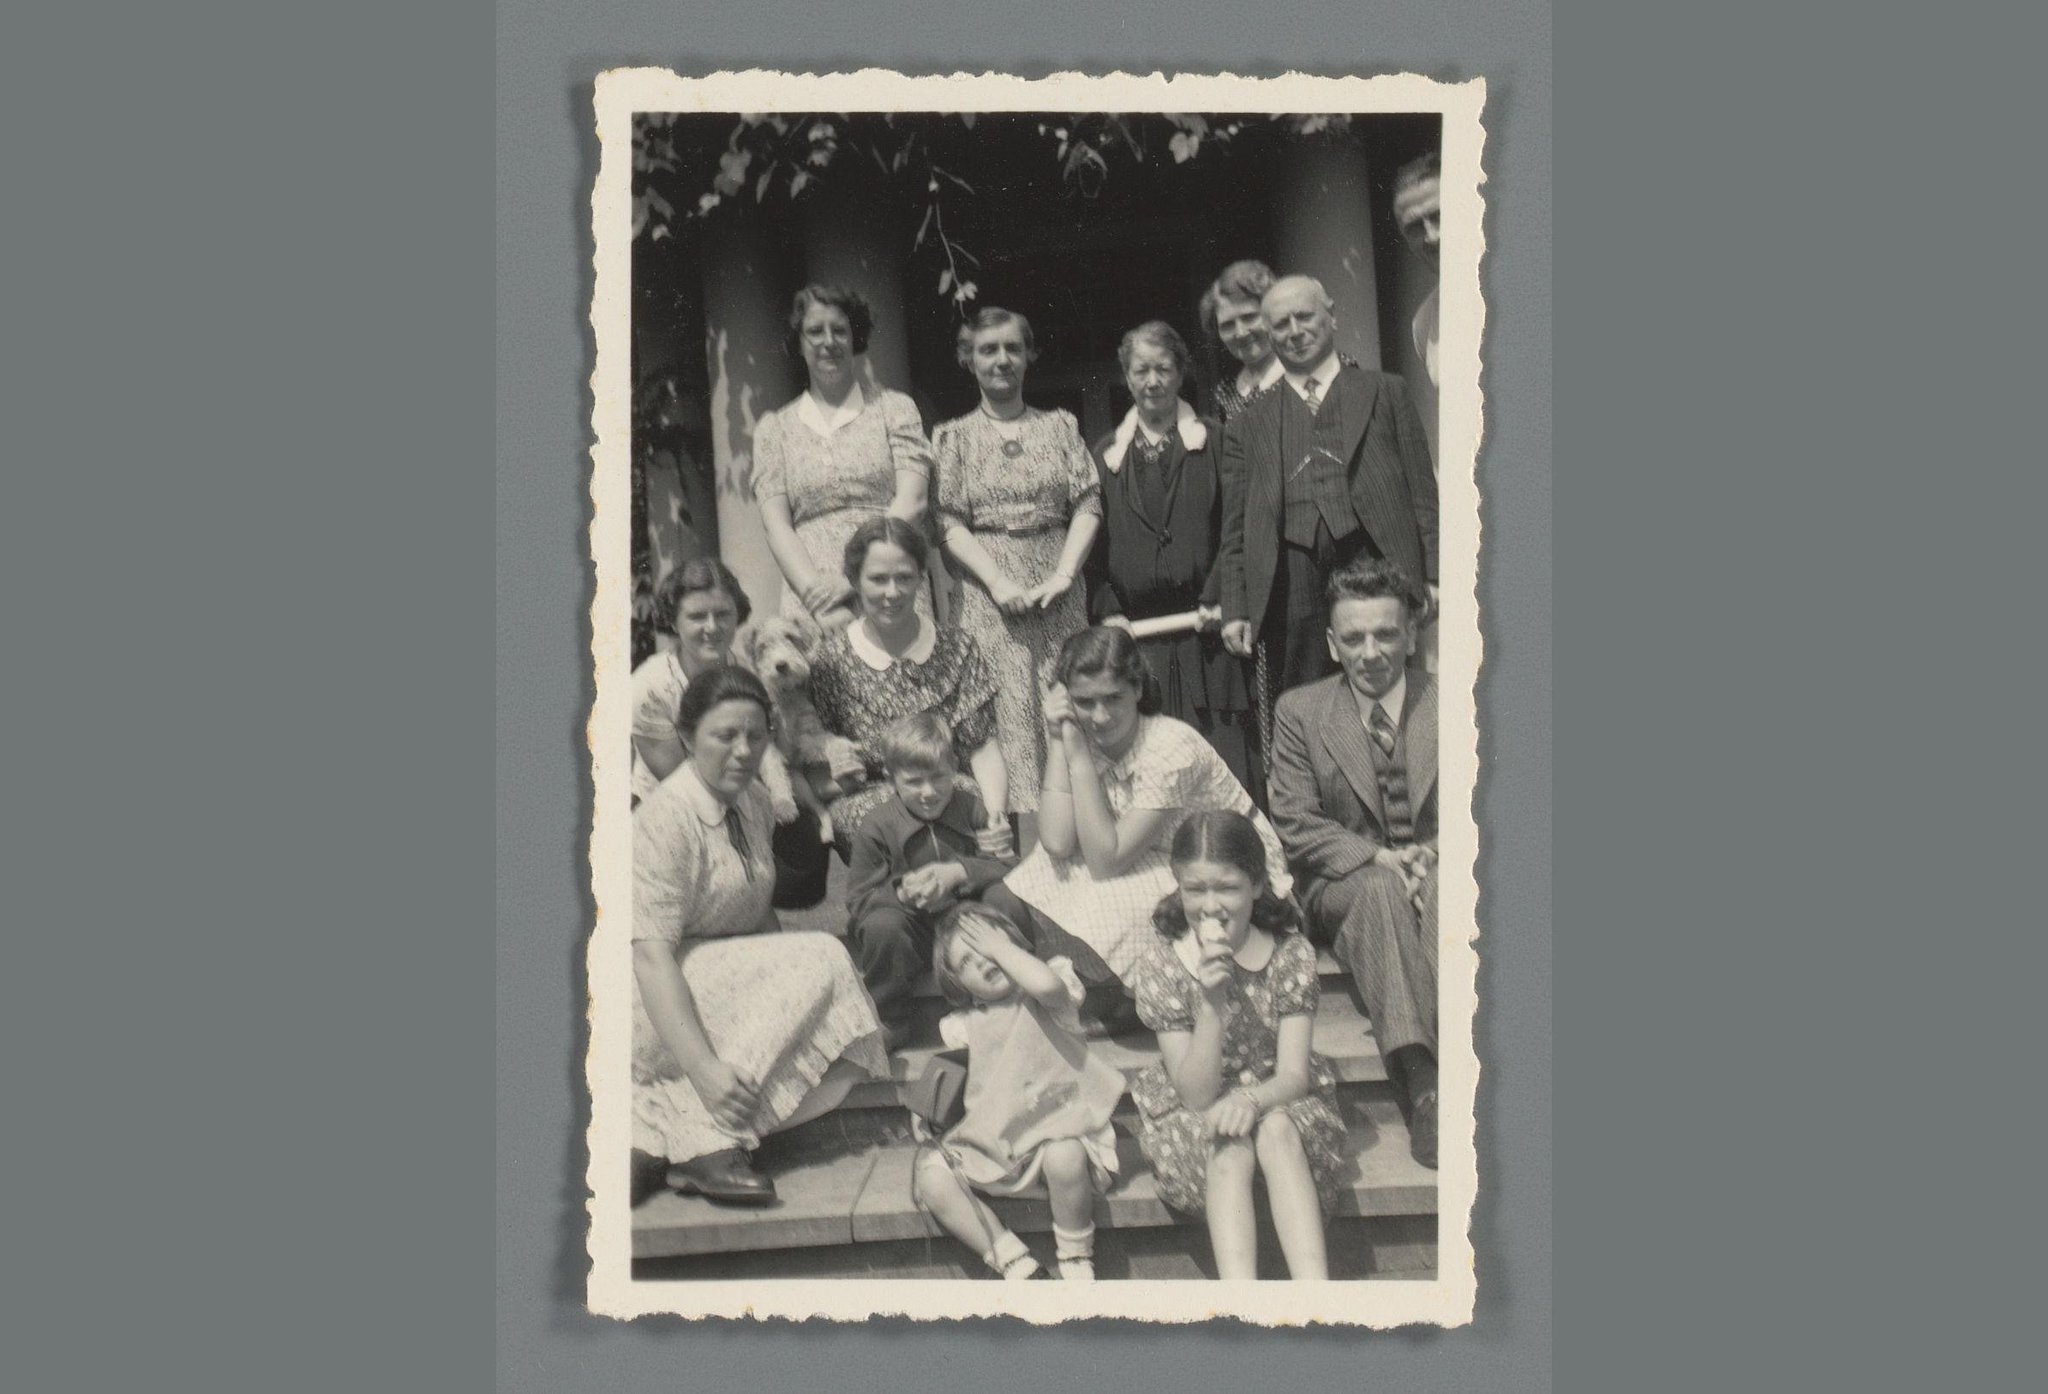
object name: photograph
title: Groepsportret van een onbekende familie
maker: Anonymous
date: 1930-1950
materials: paper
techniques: gelatin silver print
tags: family group, especially parents with their child(ren), anonymous historical persons portrayed in a group, in a group-portrait